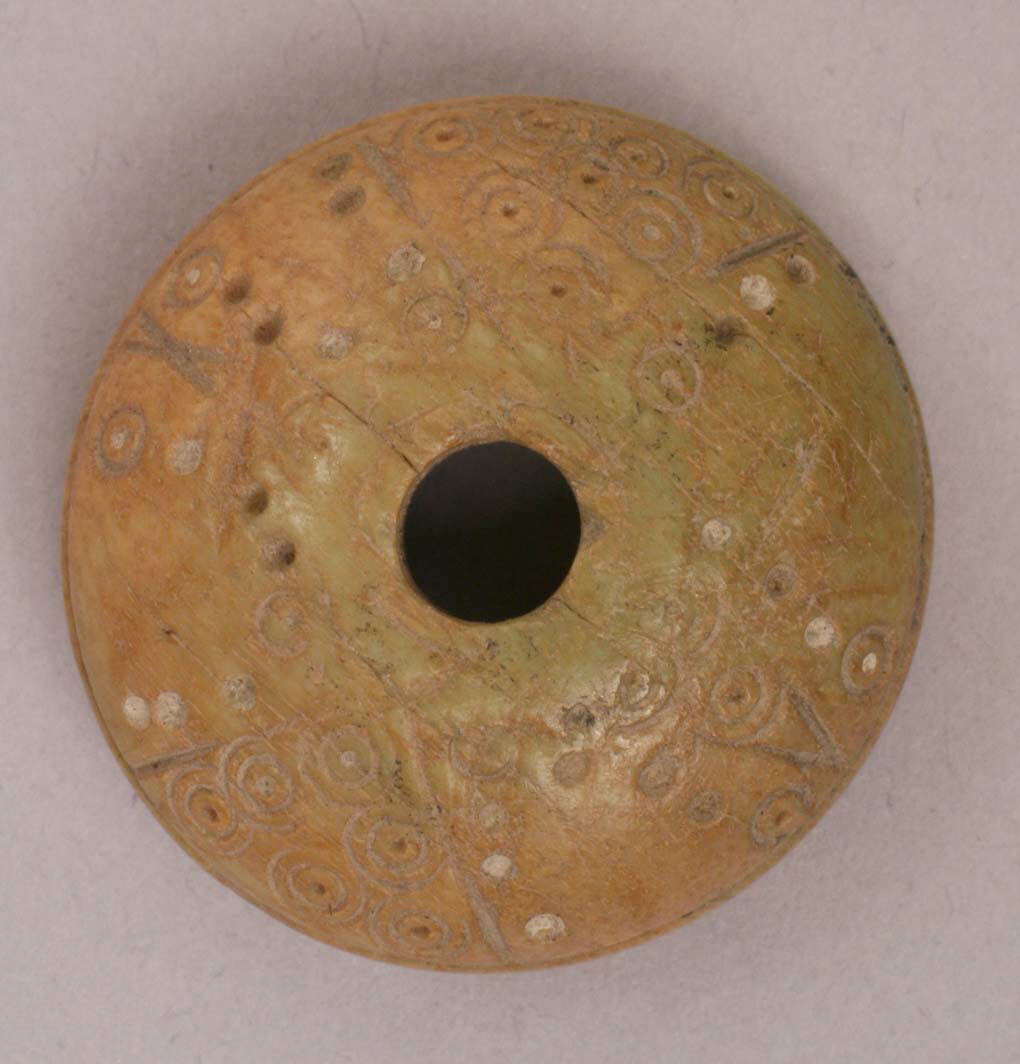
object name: button or spindle whorl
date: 801-1000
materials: bone, paint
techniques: incising, inlay, tinting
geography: iran